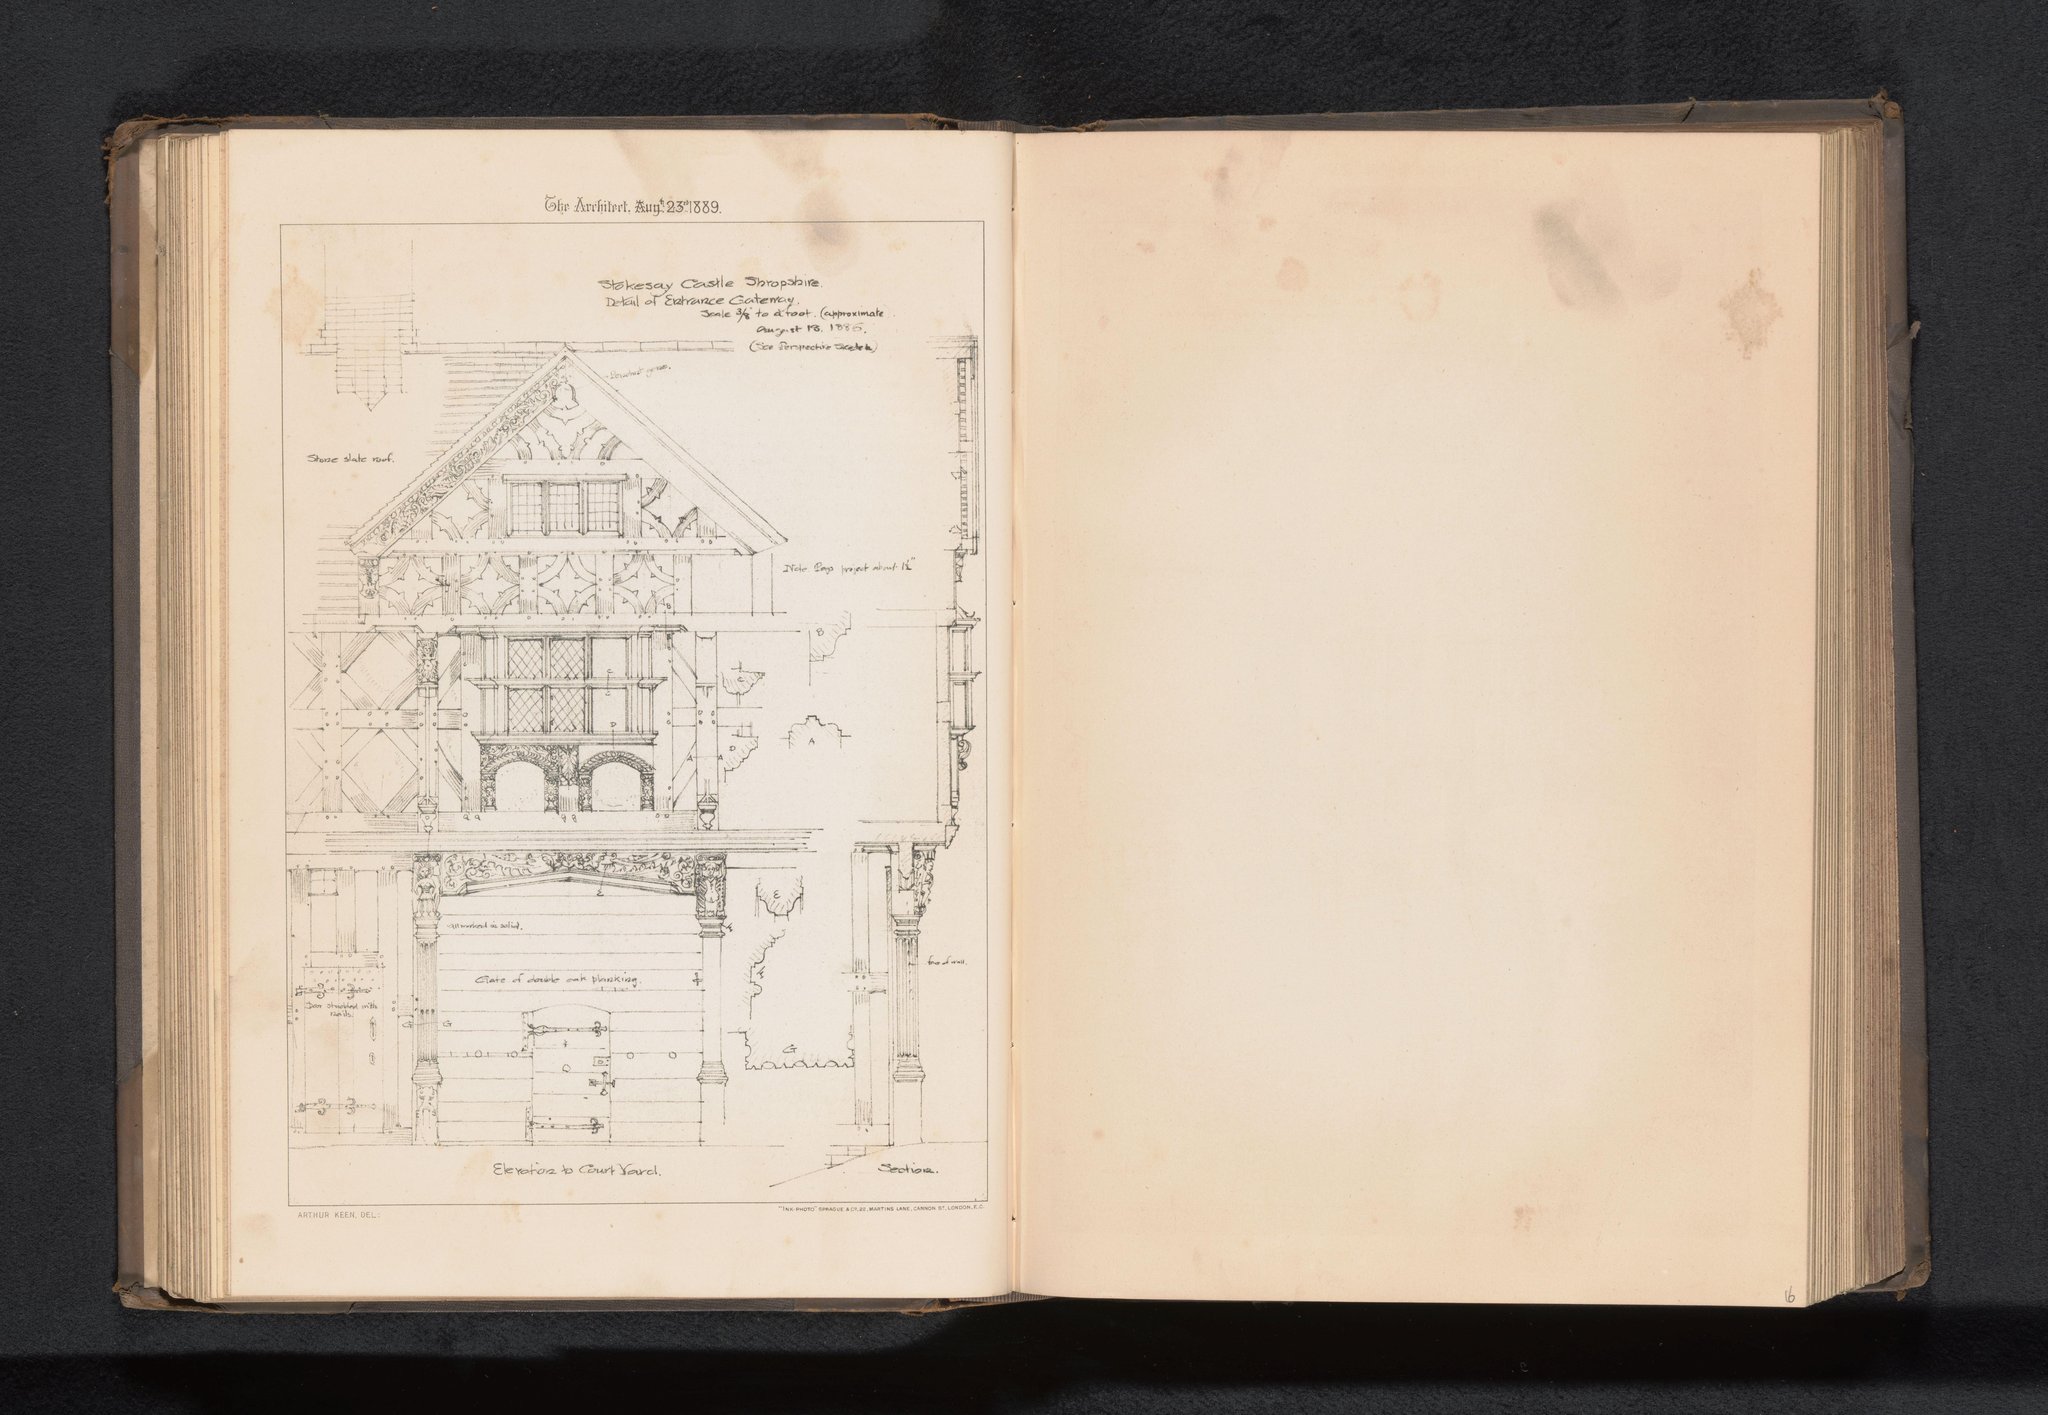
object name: page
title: Reproductie van een tekening van een ontwerp van een kasteel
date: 1884-1889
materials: paper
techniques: photolithography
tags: castle, designing, sketching ~ architect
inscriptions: inscription: ‘Arthur Keen, Del:’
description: Prent op tweede ongenummerde pagina na pagina 104.